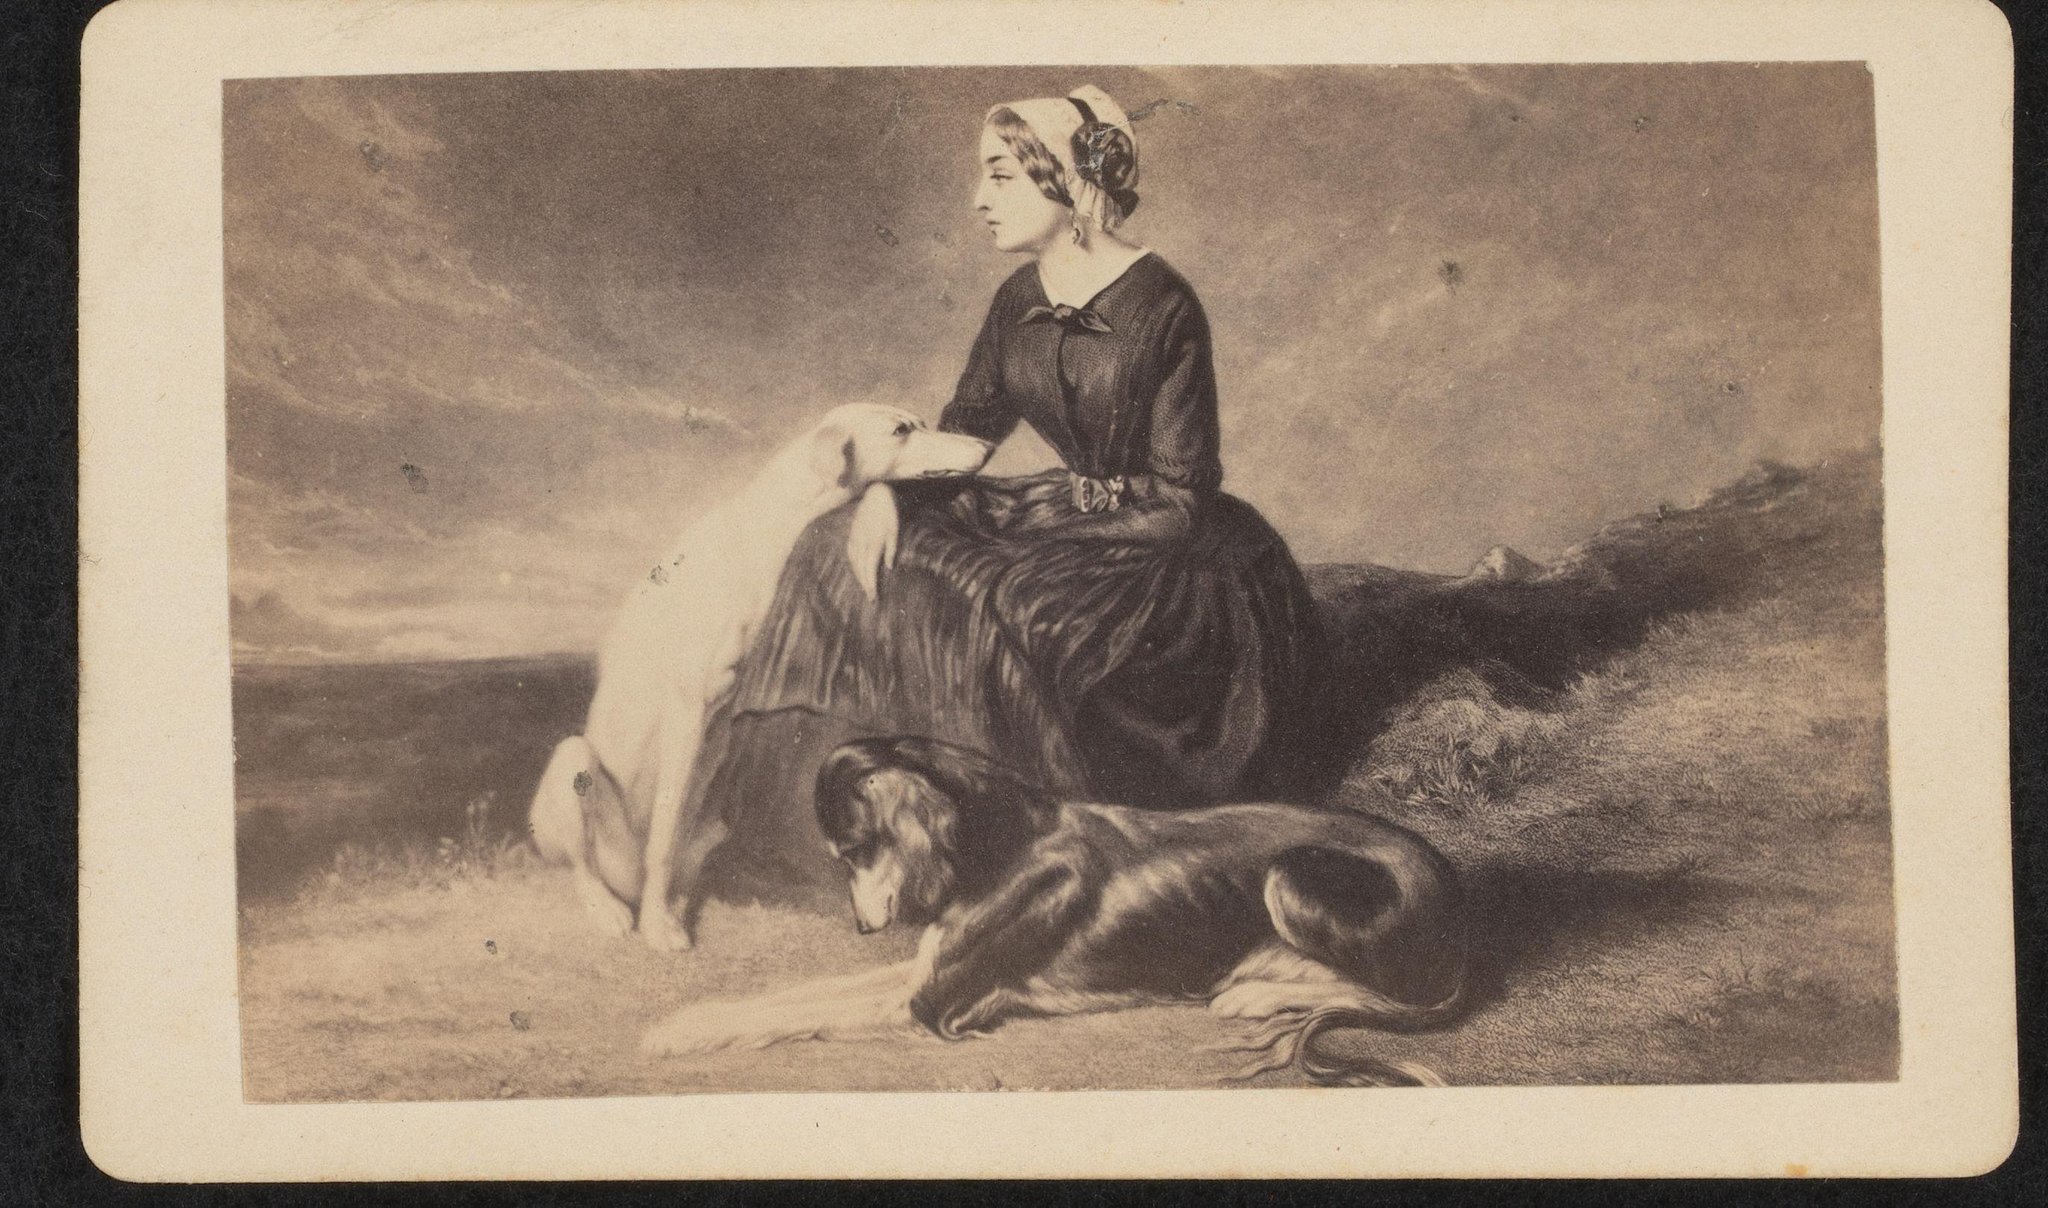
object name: carte de visite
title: Fotoreproductie van een schilderij, vrouw met twee honden in landschap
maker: alfred de dreux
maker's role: fotograaf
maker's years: 1810-1860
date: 1860-1900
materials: cardboard, photographic support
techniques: albumen print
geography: berlin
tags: landscapes, dog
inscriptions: inscription: ‘102./ Alfed de Dreuz/ La douleur partagée/ Der getheilte Schmerz/ The divided grief (...) Berlin’